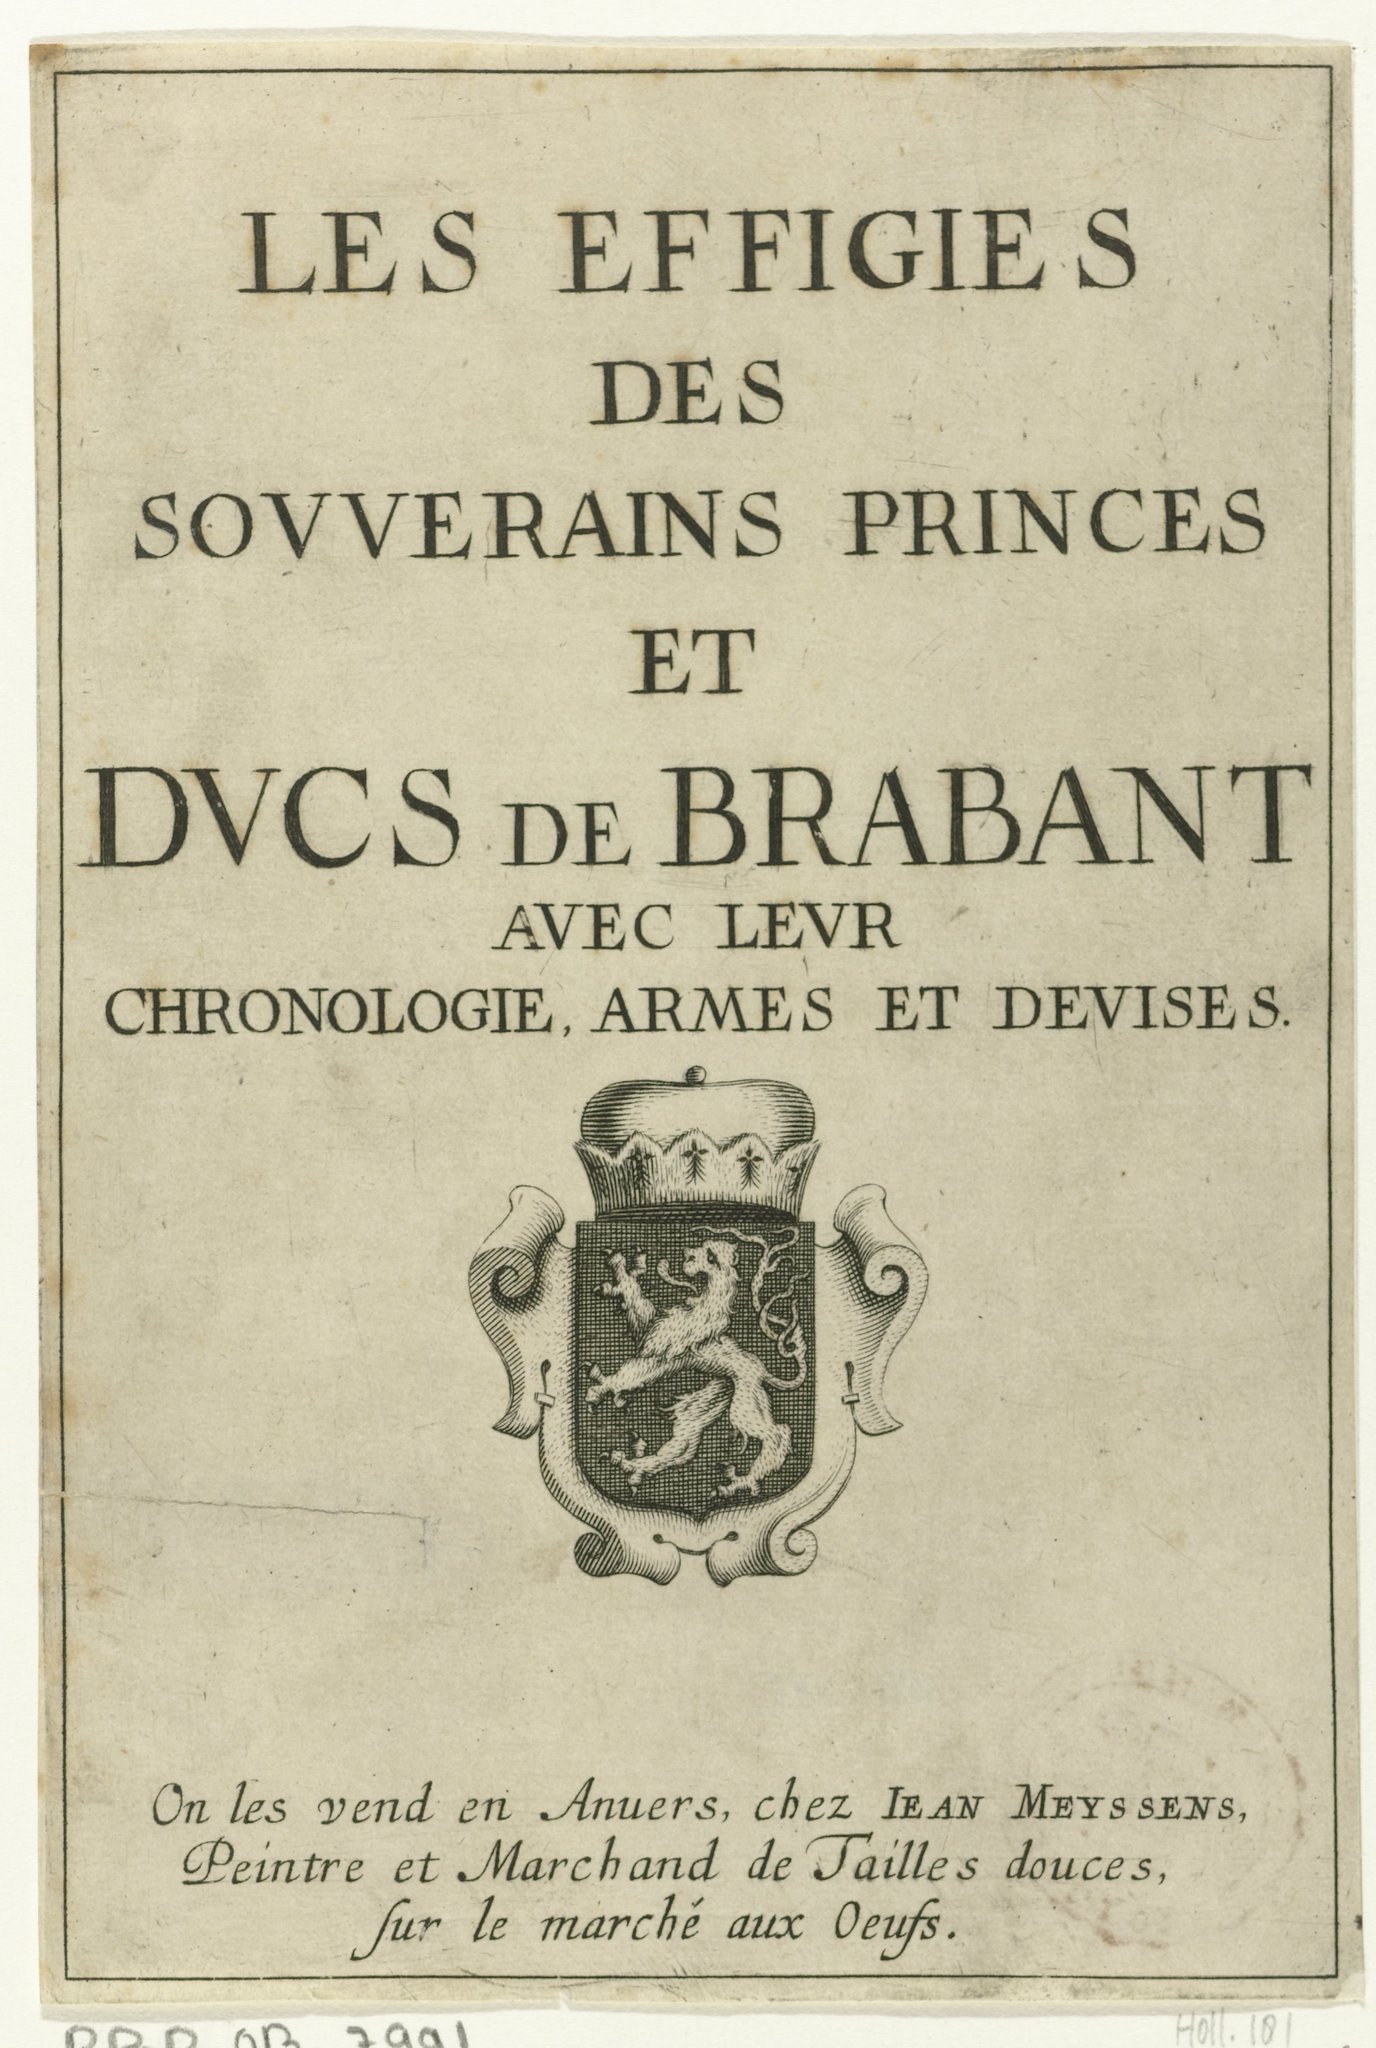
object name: print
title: Titel en wapenschild van Hertogdom Brabant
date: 1661-1663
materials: paper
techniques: engraving, etching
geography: antwerp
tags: coat of arms (symbol of sovereignty)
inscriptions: collector's mark: Lugt 240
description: Titelpagina voor: Meyssens, Joannes, Les effigies des souverains princes et ducs de Brabant avec leur chronologie, armes et devises. Antwerpen: Joannes Meyssens, na 1661.